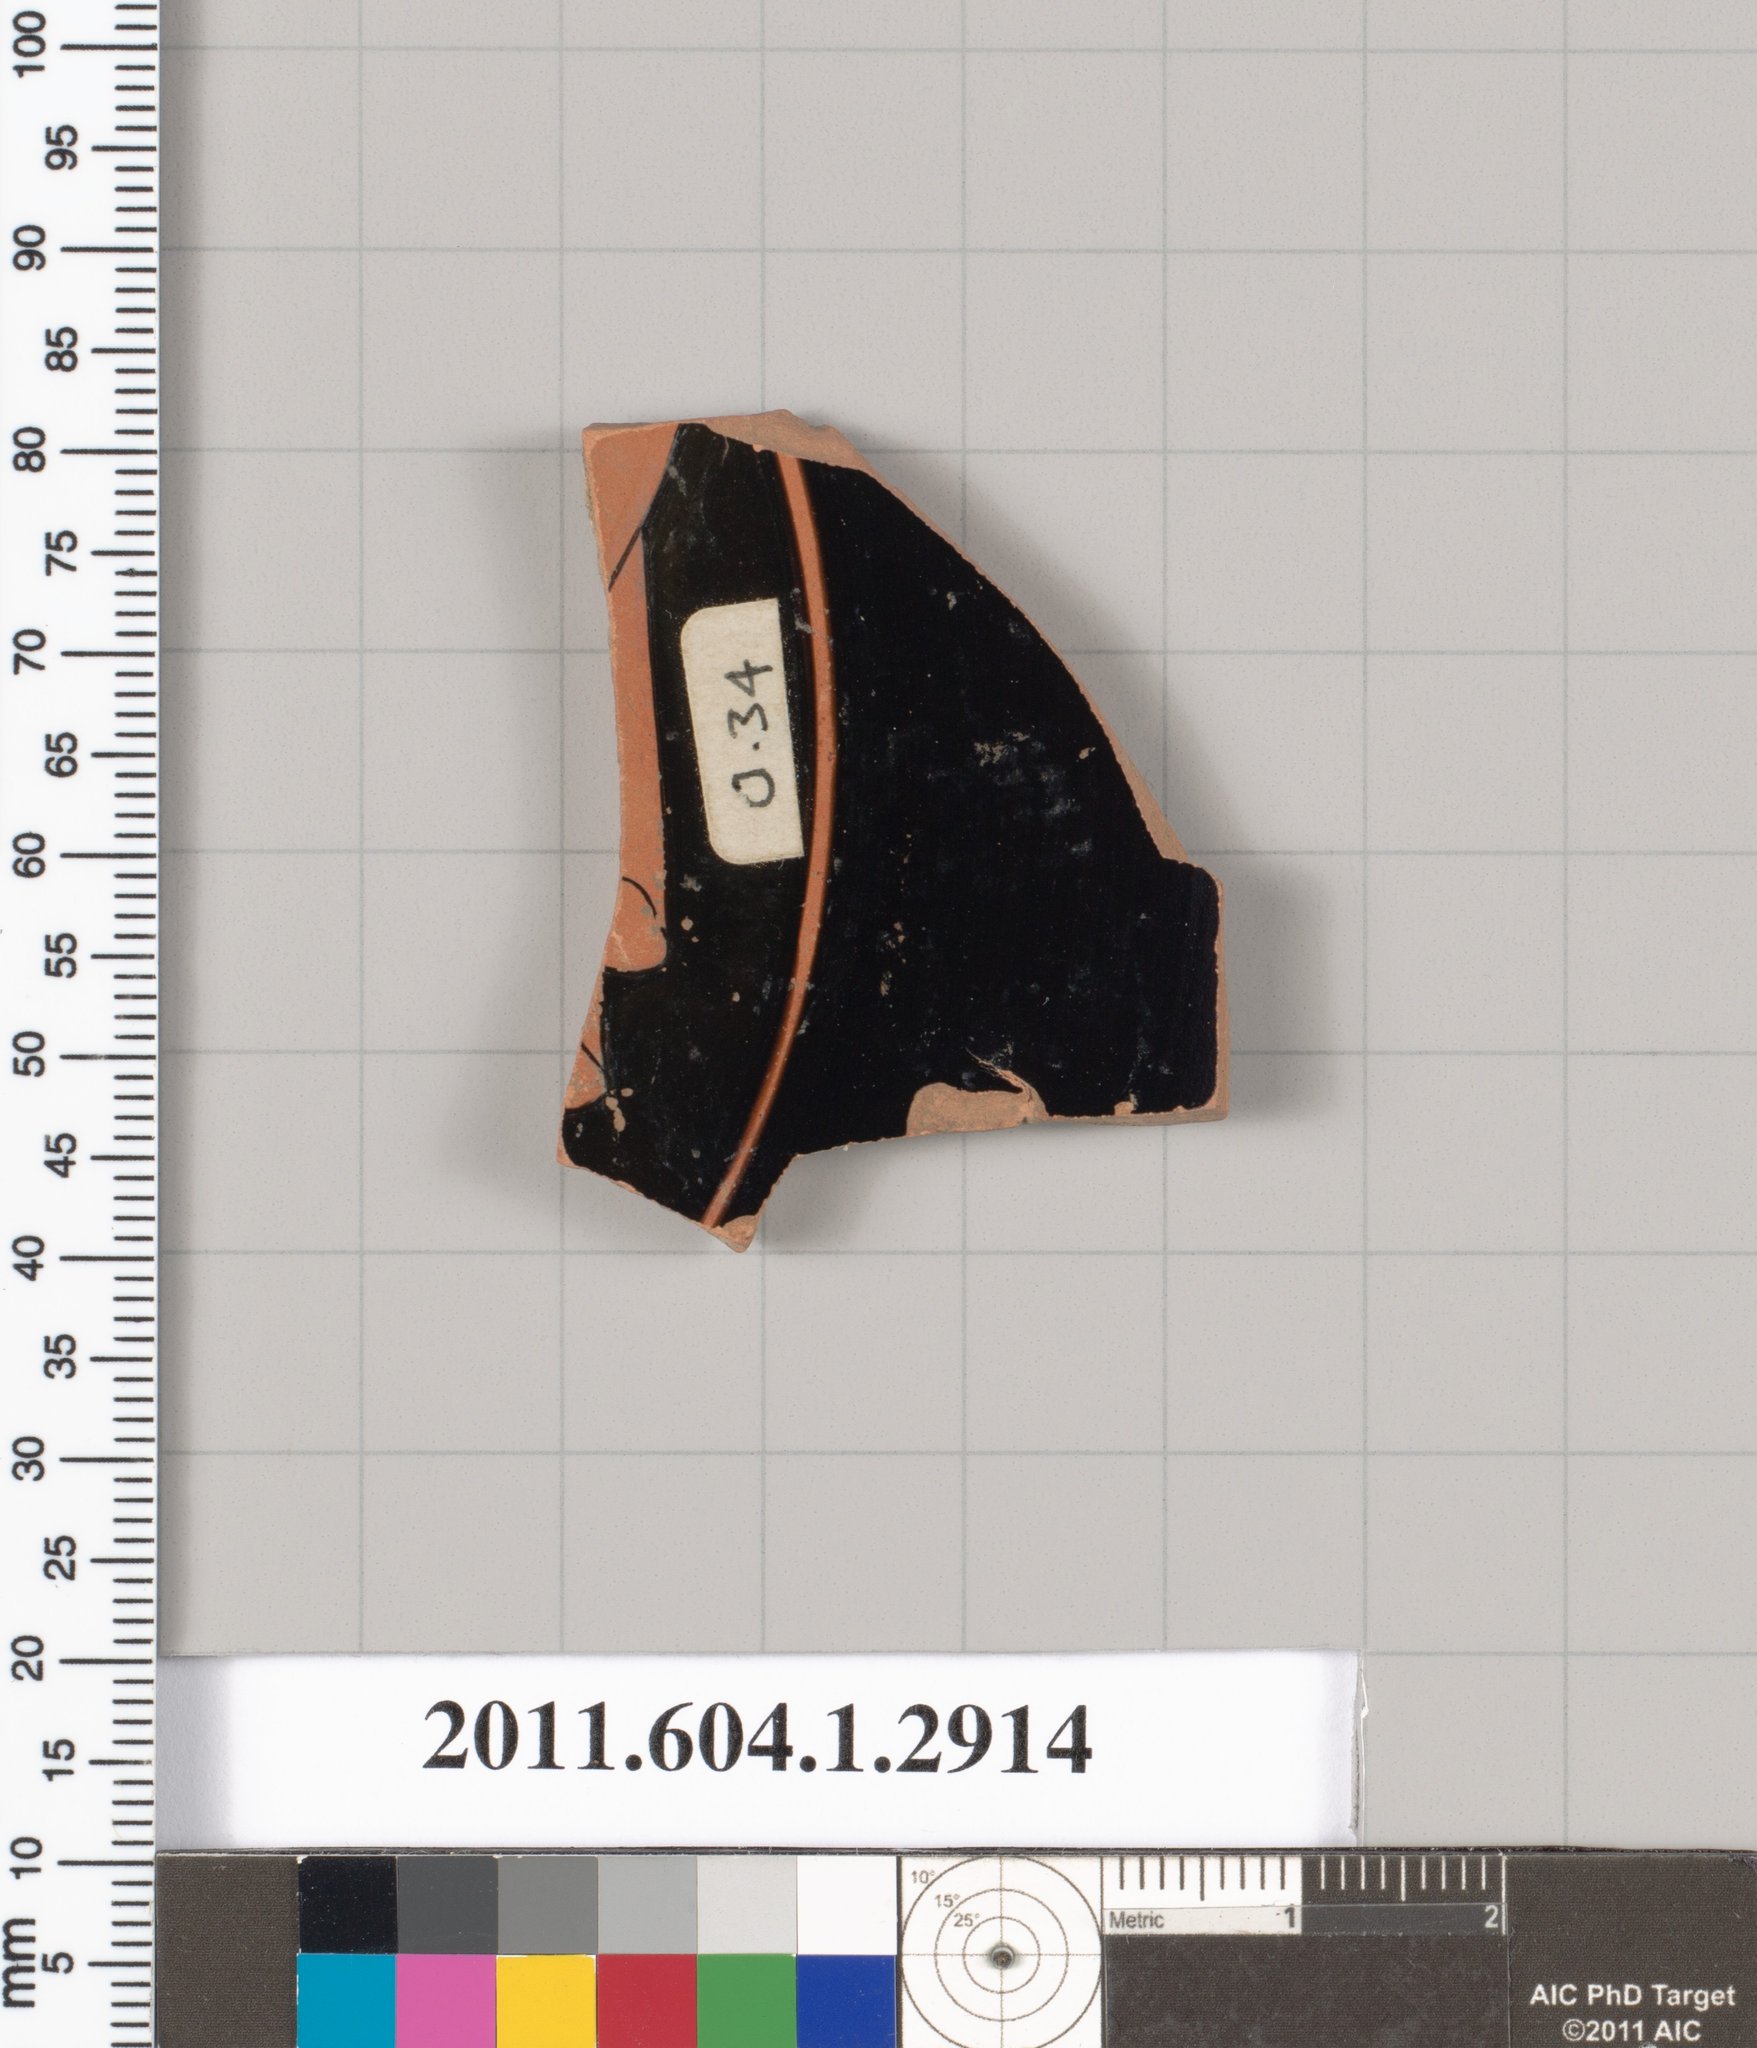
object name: kylix fragment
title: Terracotta fragment of a kylix (drinking cup)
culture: greek, attic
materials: terracotta